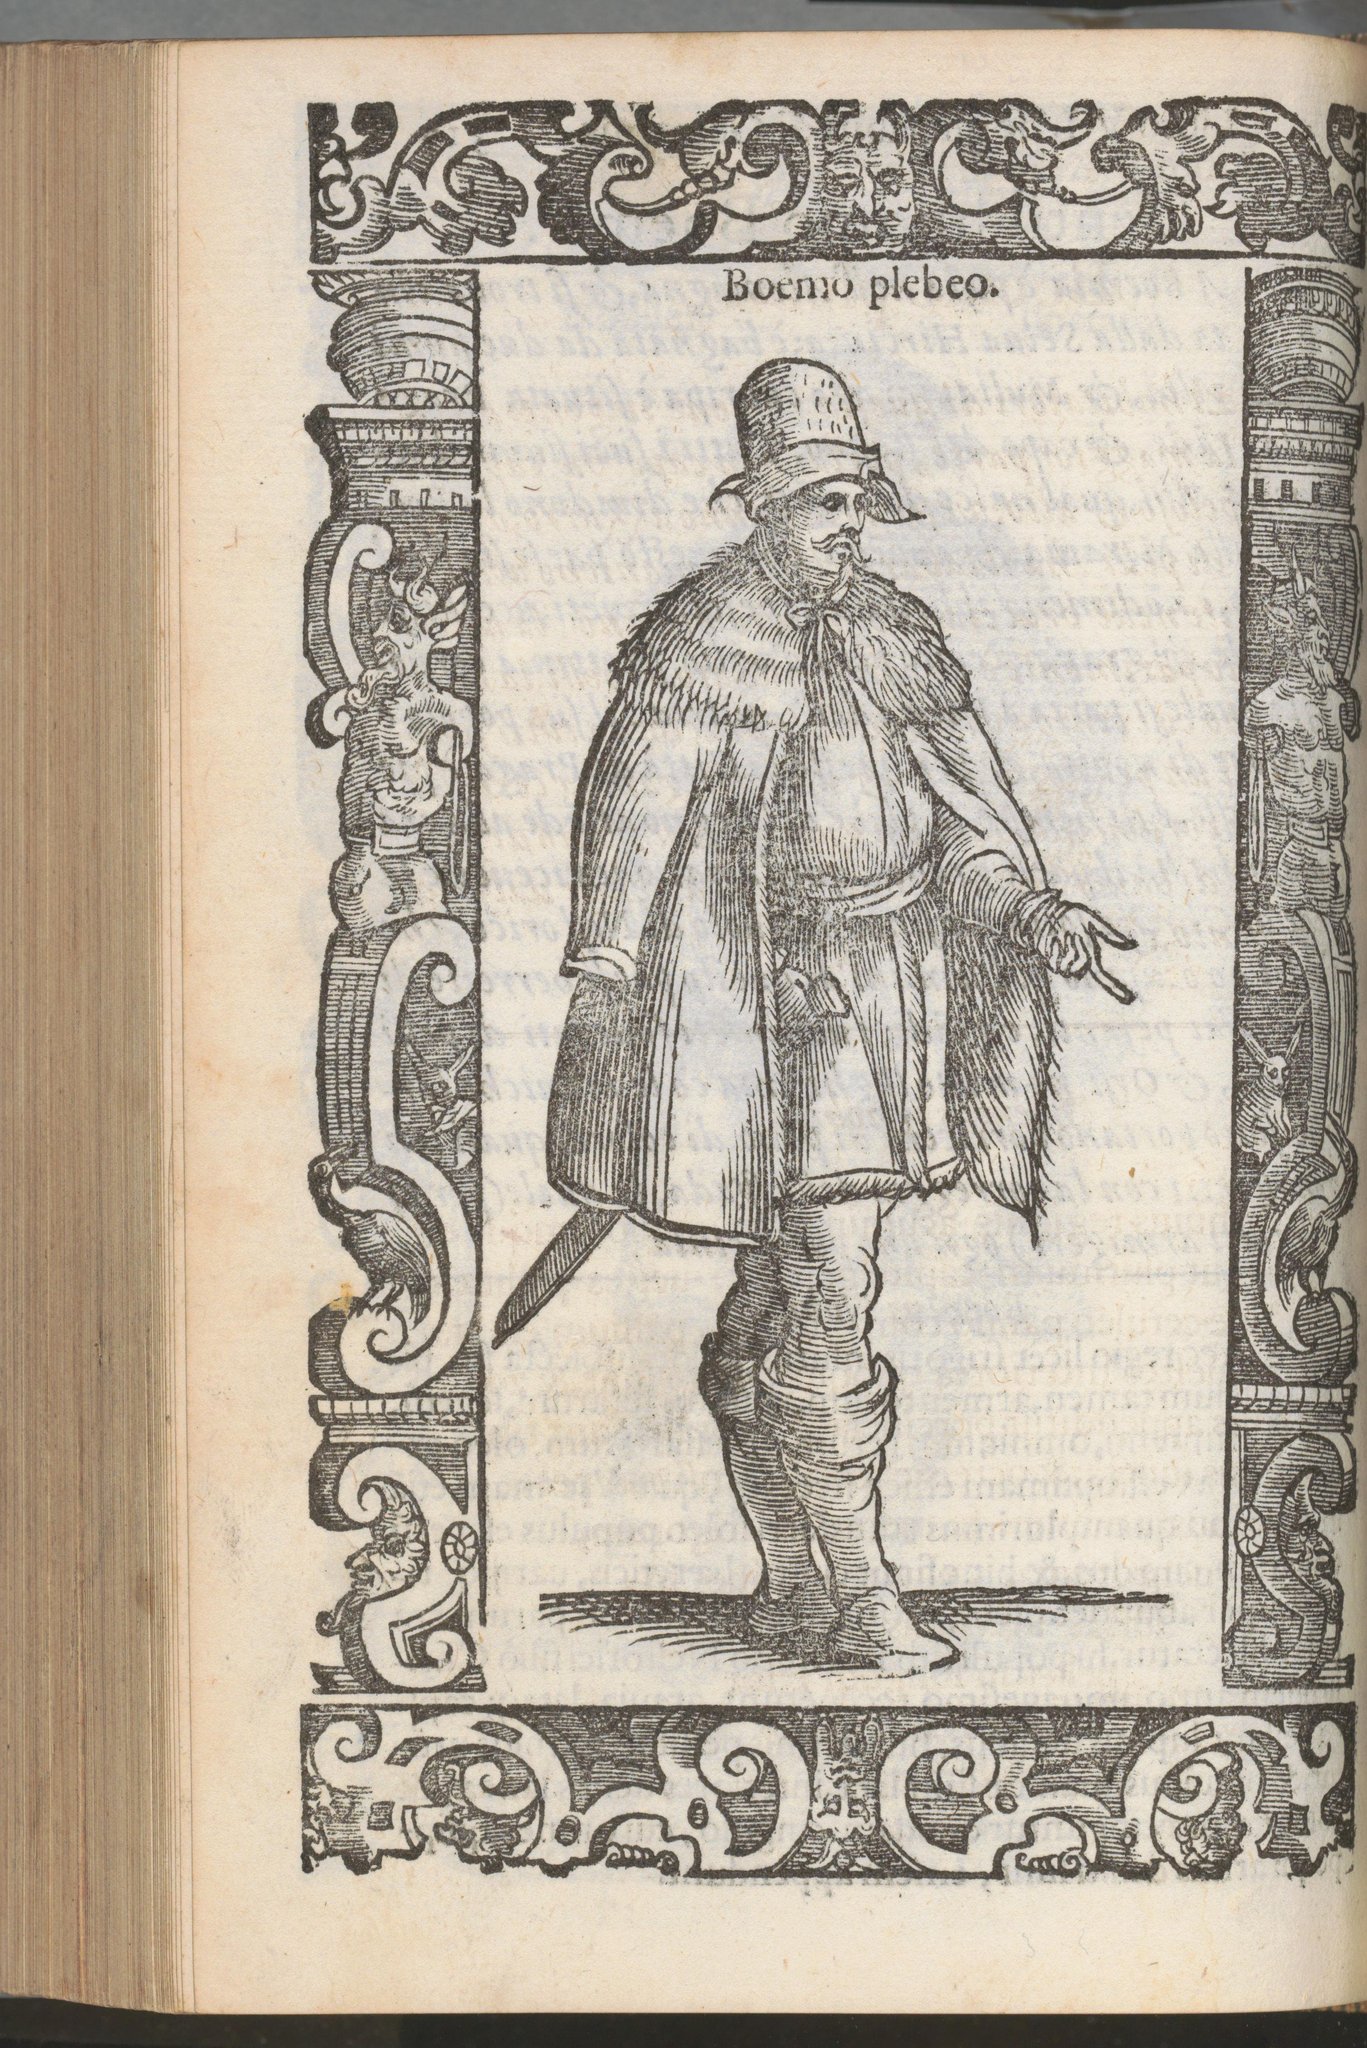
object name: costume print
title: Habiti antichi, et moderni di tutto il mondo...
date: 1598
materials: paper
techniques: woodcut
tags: fashion plates